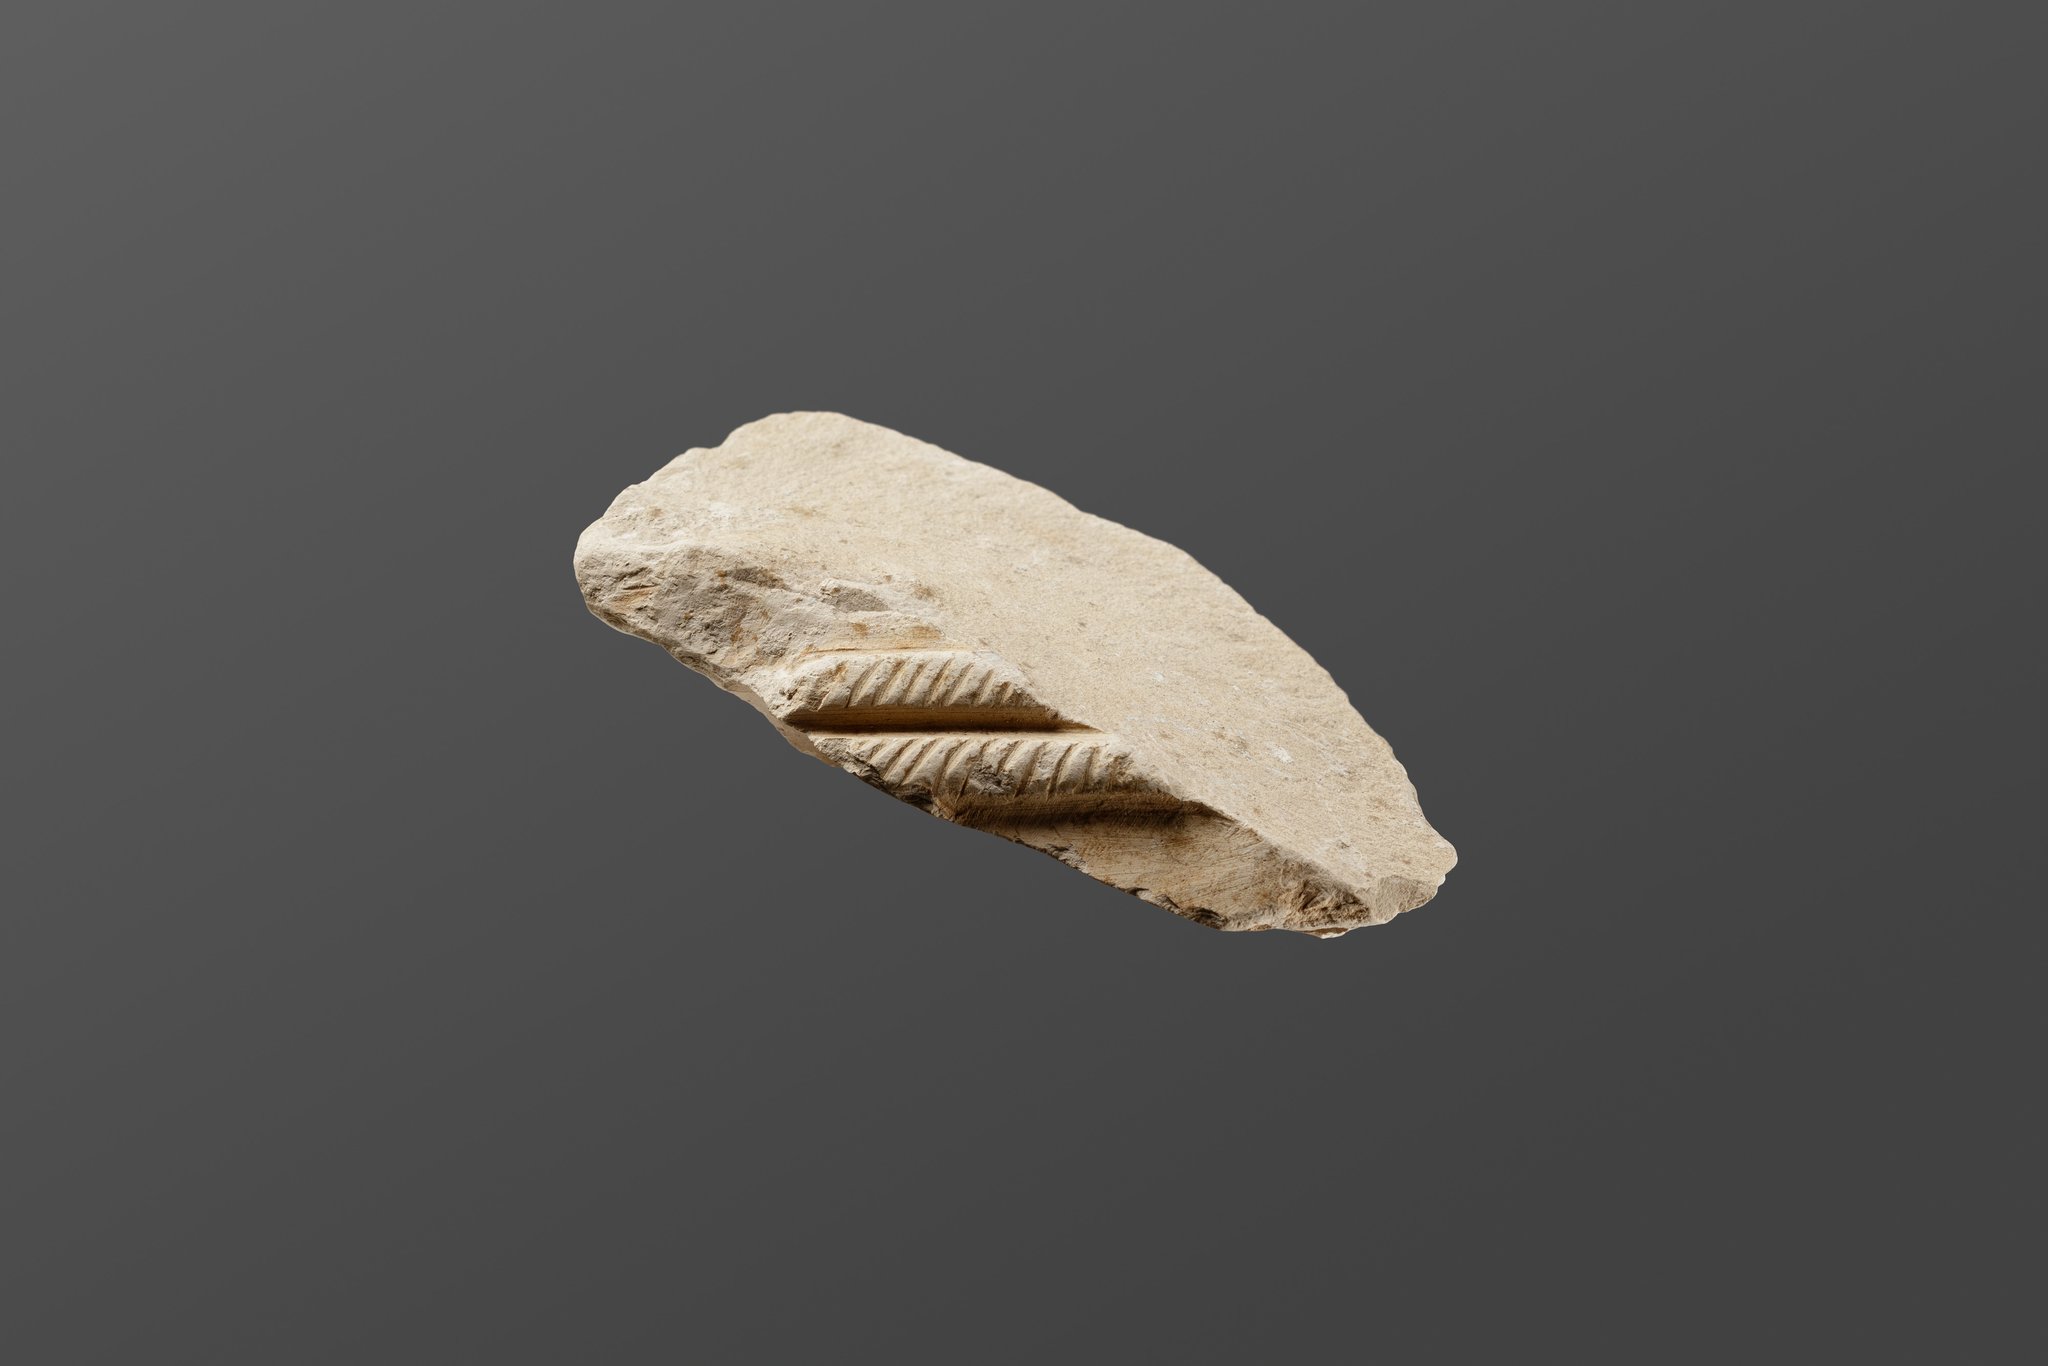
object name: relief fragment 41, tomb of mereri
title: Relief fragment possibly from the tomb of Mereri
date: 2100-2090 BCE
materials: limestone